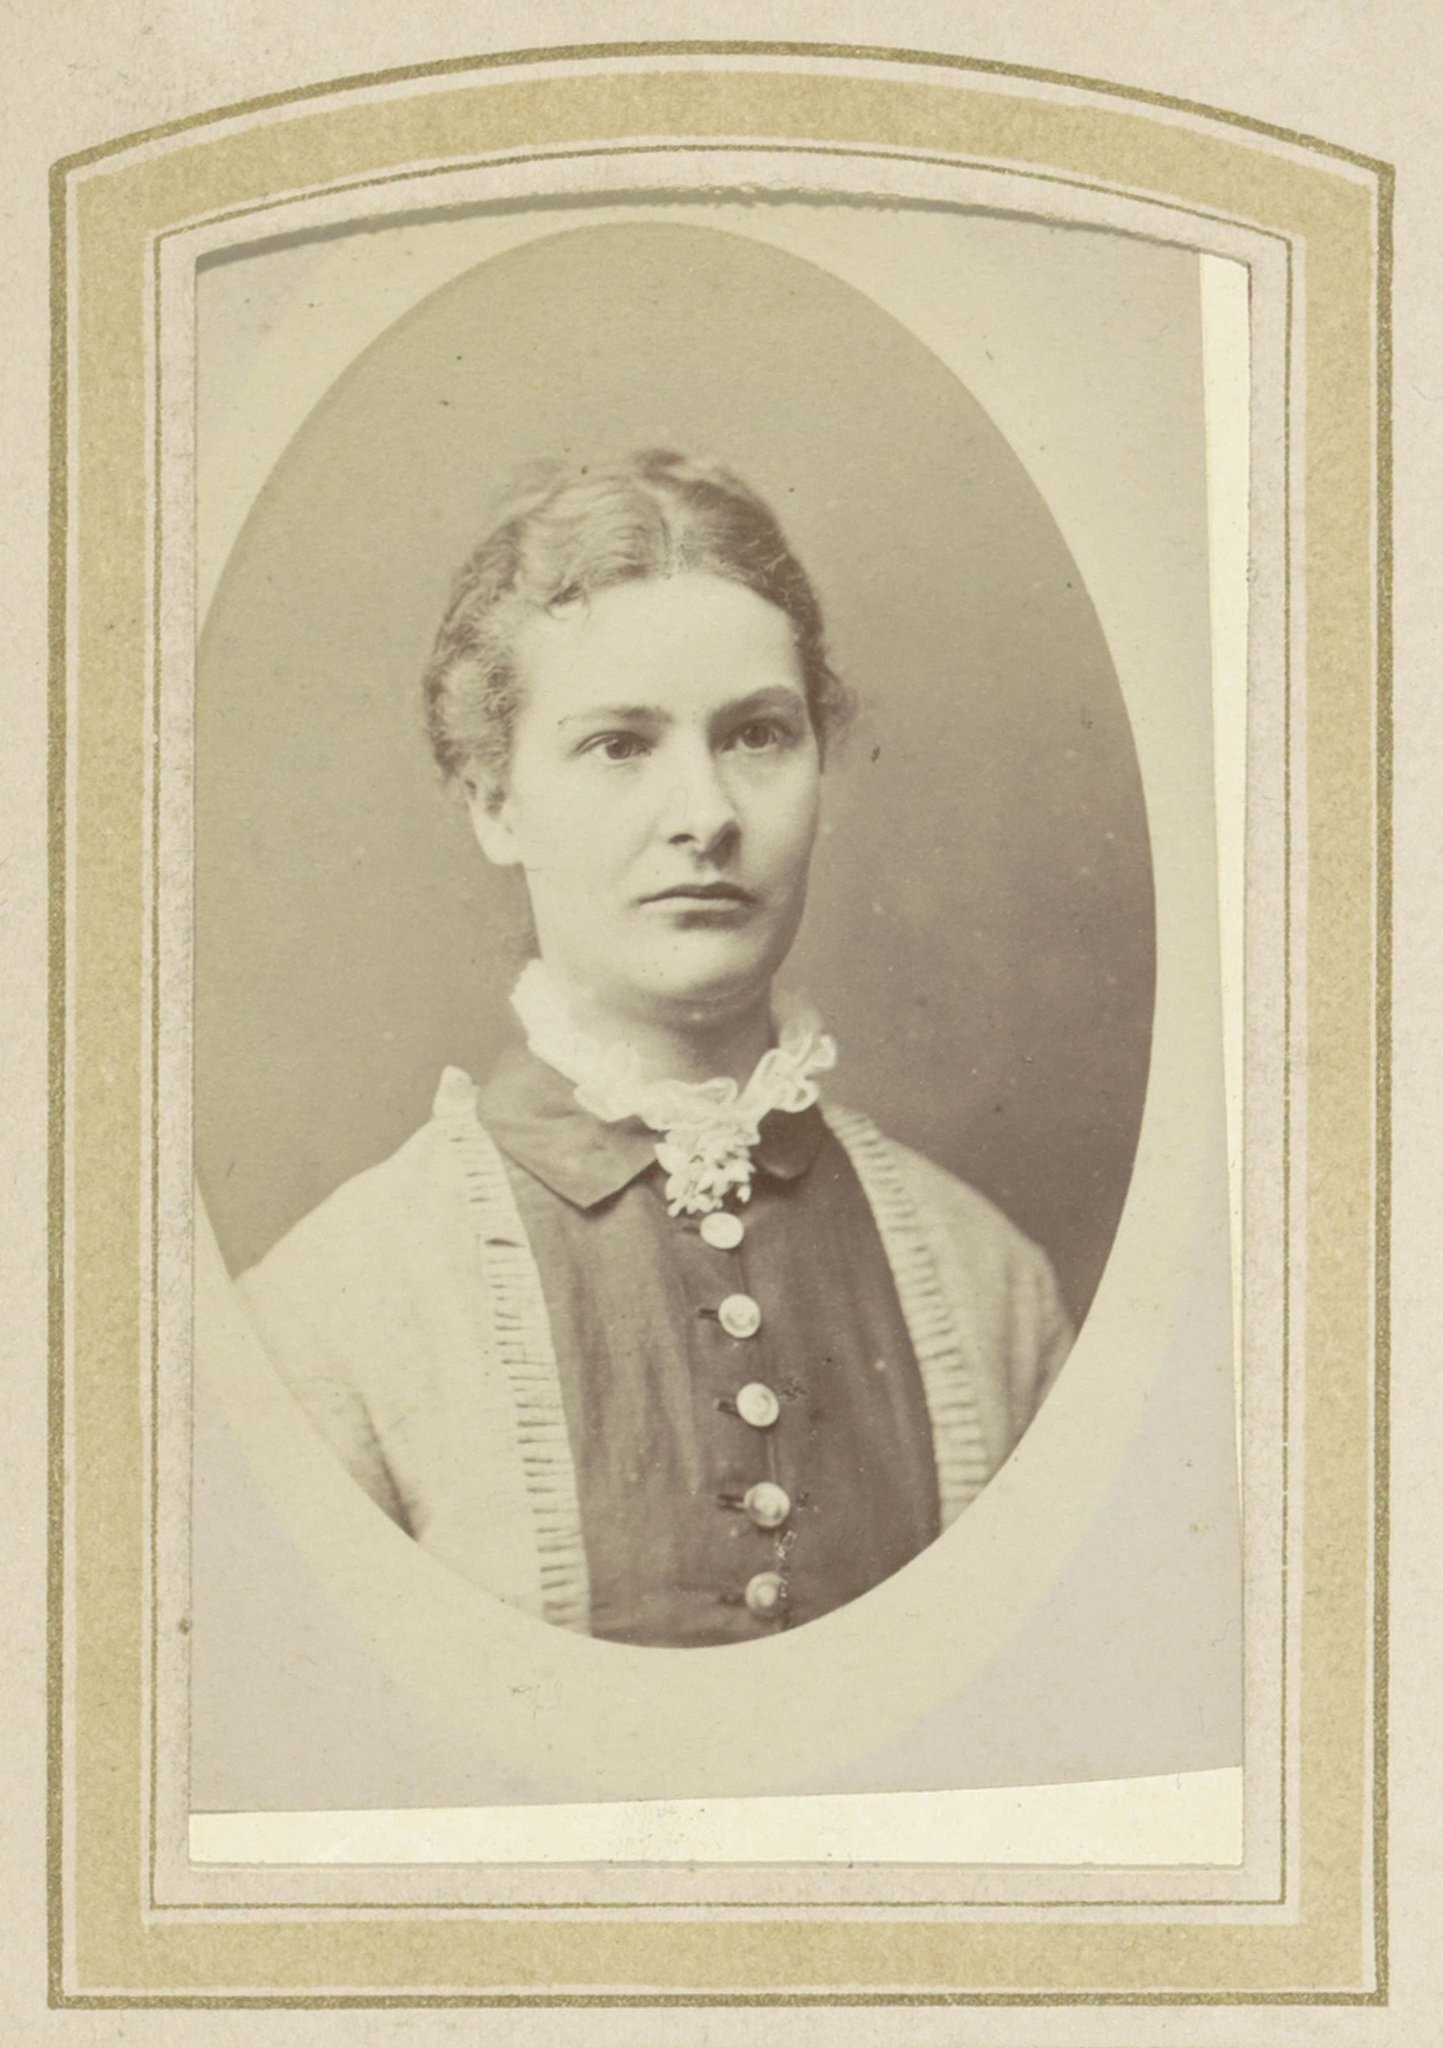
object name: photograph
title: Portret van een vrouw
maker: johannes ephraim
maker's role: fotograaf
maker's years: 1838-1921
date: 1867-1904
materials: cardboard, paper, photographic support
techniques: albumen print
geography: arnhem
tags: historical persons, neck-gear ~ clothing, clothing for the upper part of the body, arnhem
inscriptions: address: ‘Rijnkade 312 Arnhem’, address: ‘Arnhem’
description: Onderdeel van Fotoalbum van een Nederlandse familie met 168 cartes-de-visite en kabinetfoto's.